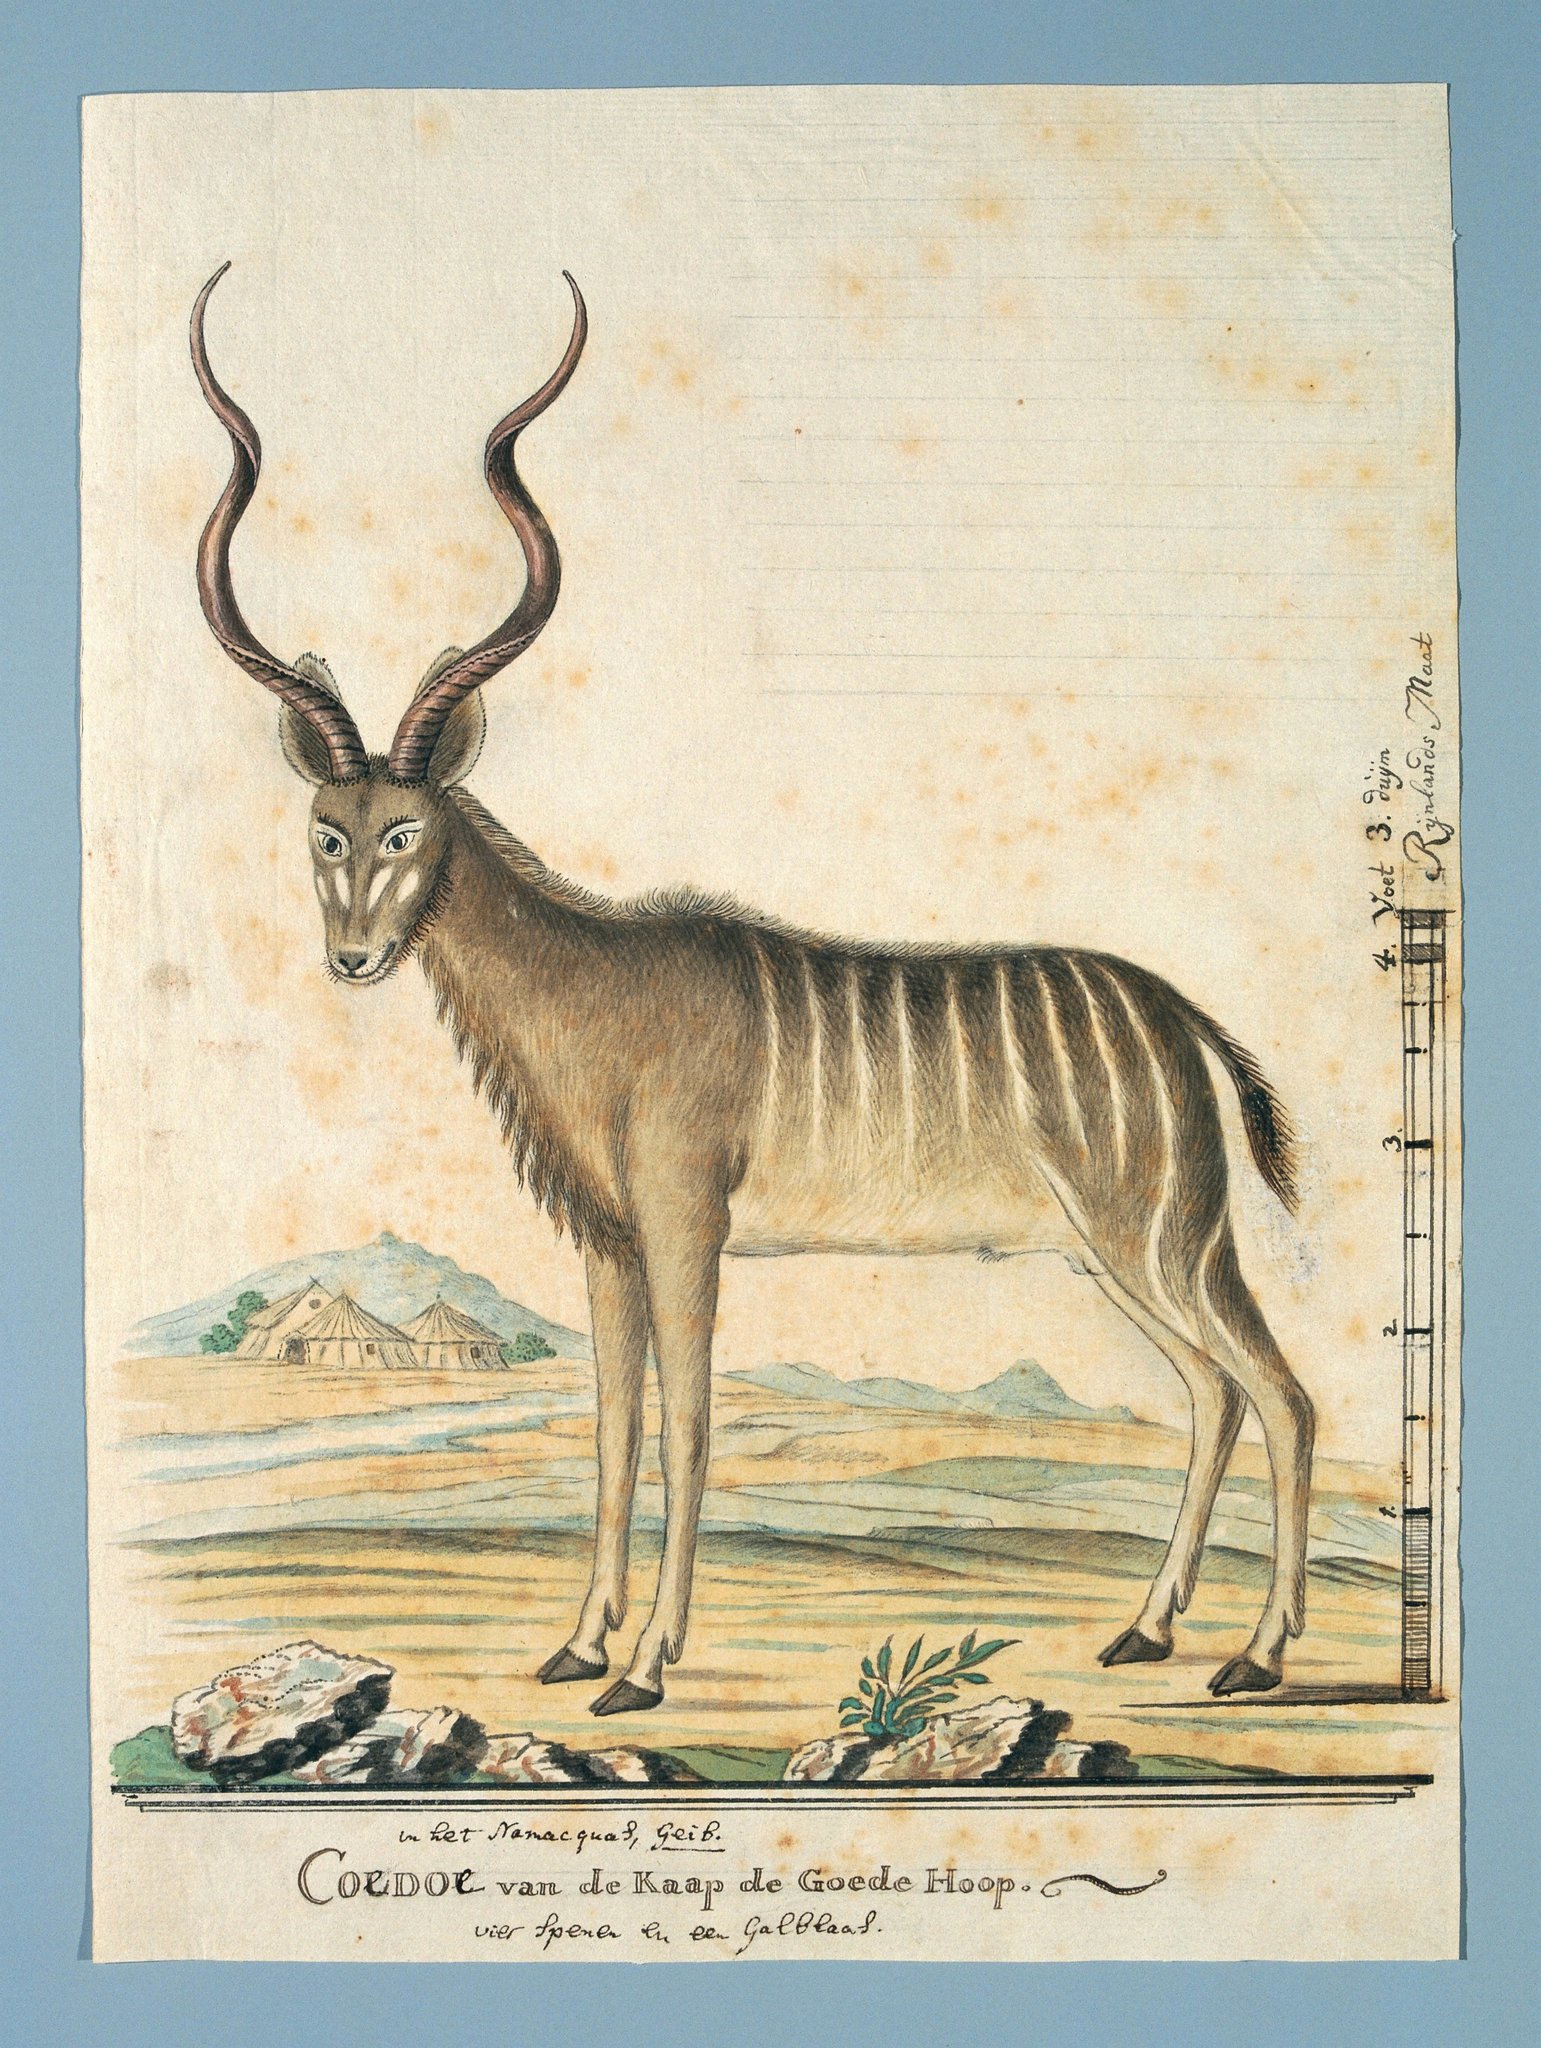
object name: album leaf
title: Tragelaphus strepsiceros (Greater kudu)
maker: robert jacob gordon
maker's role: draughtsman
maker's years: 1743-1795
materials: paint, ink, paper, pencil, watercolor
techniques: brush, pen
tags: animals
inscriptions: annotation: ‘in het Namaquaas, Geib [onderstreept] / COEDOE van de Kaap de Goede Hoop. ~ / vier Spenen en een galblaas. ; 4. Voet 3. duijm / Rijnlands Maat. naast schaalverdeling’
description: Een levend exemplaar bevond zich een tijdje in de stadhouderlijke menagerie en werd door Aert Schouman getekend.